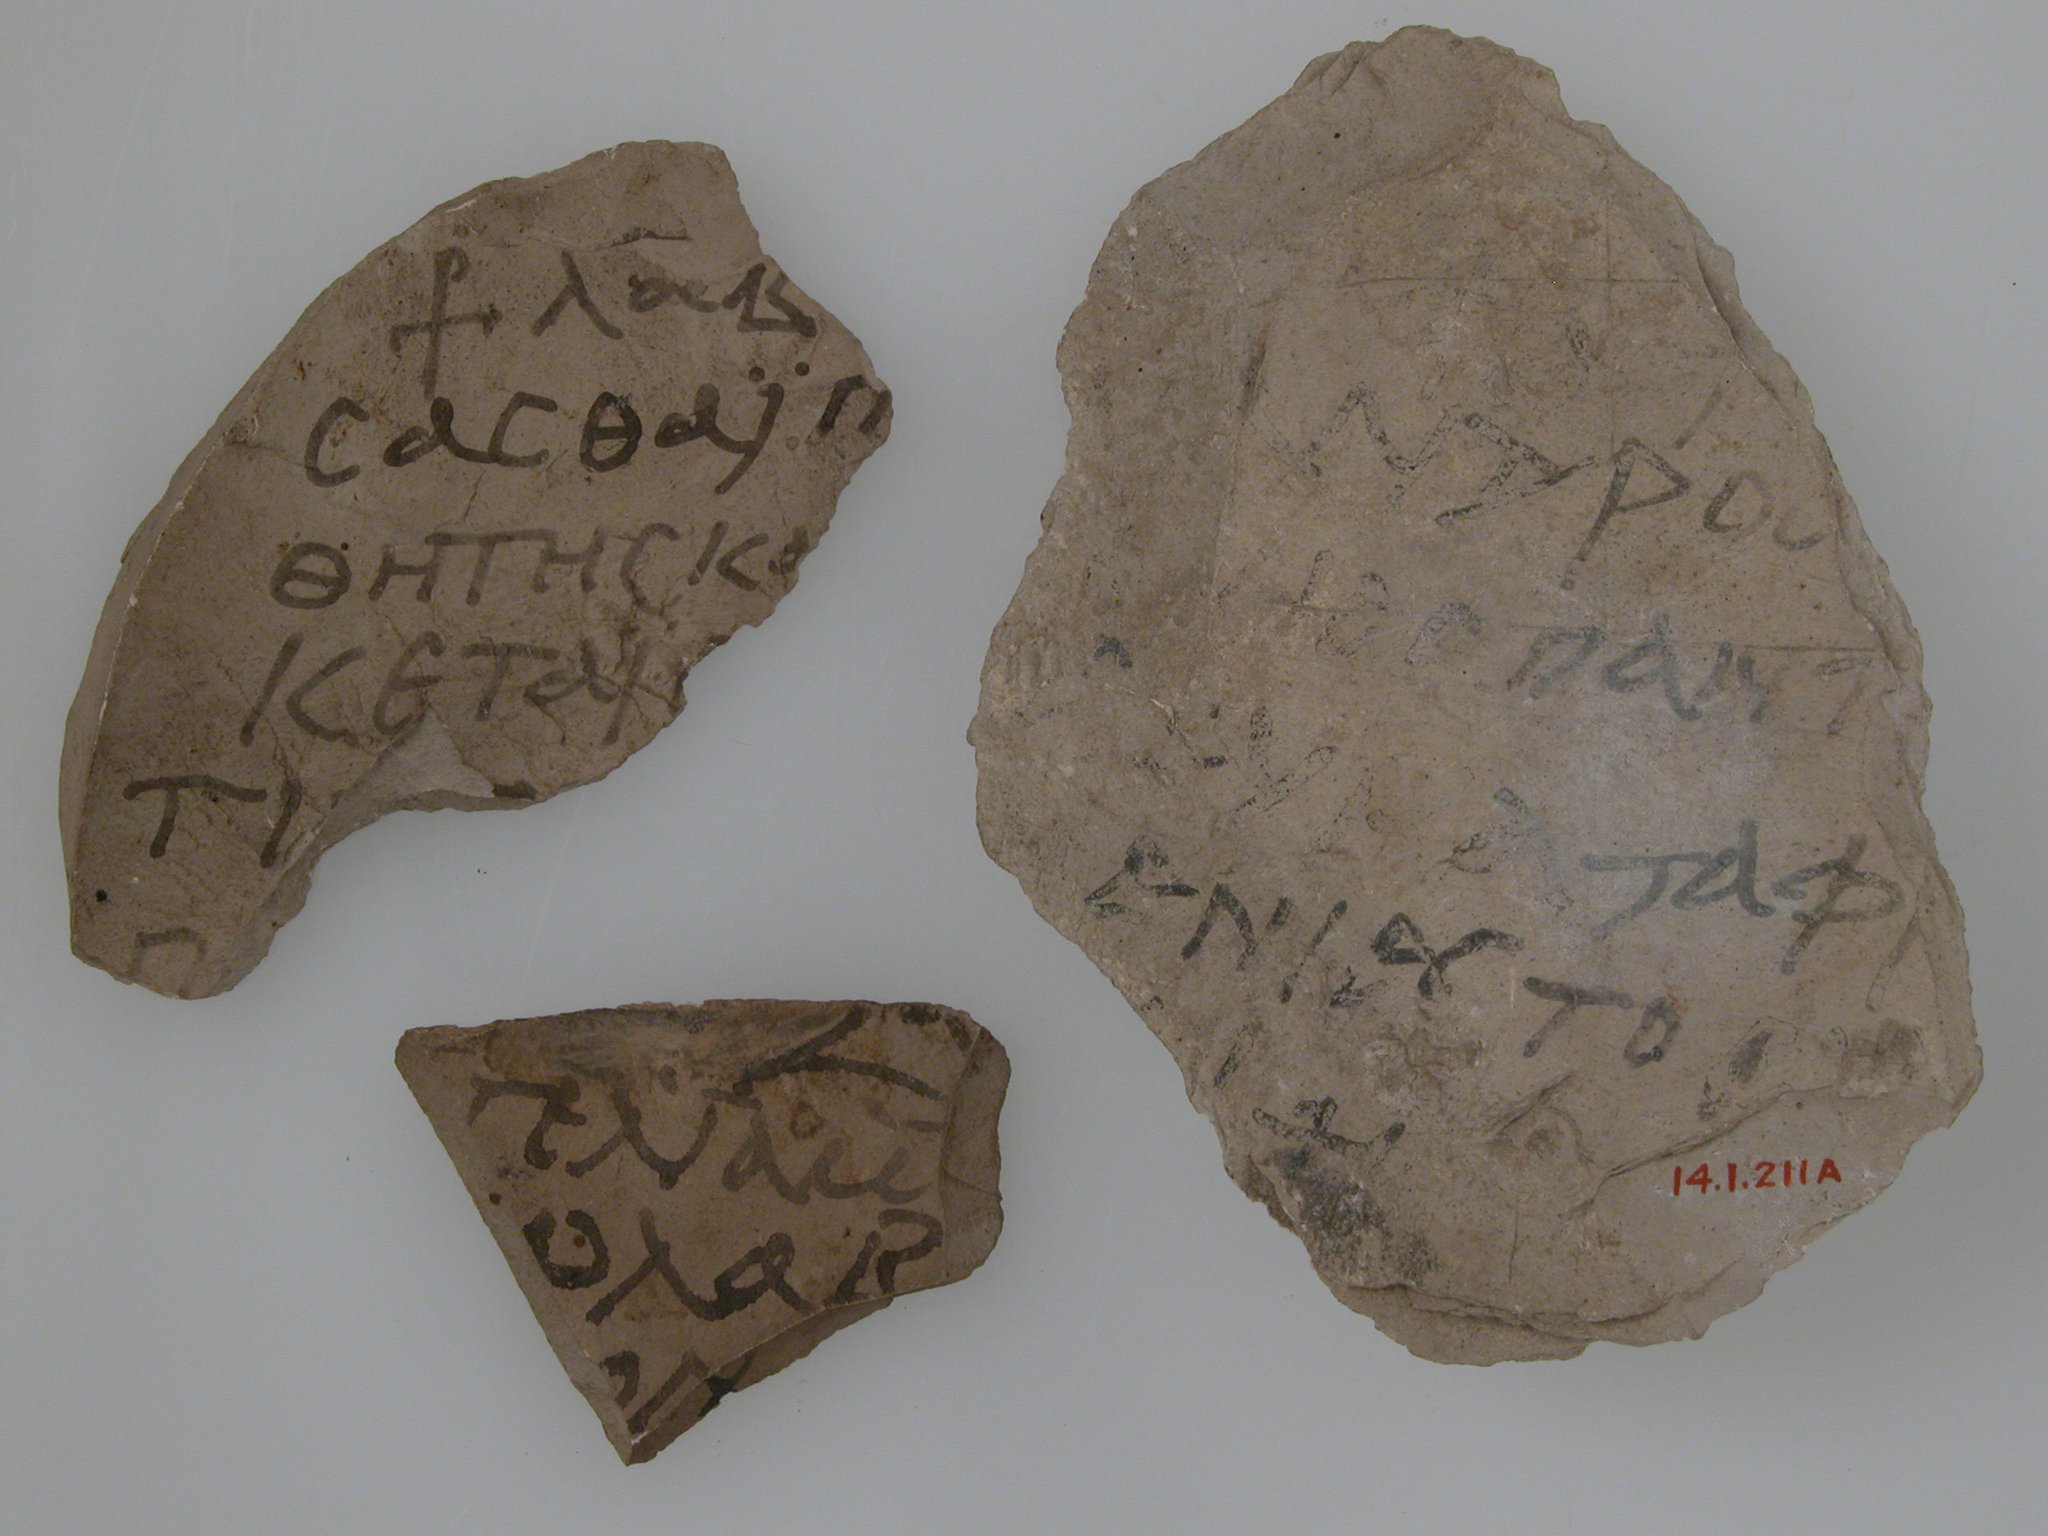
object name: ostrakon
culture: coptic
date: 580-640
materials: ink, limestone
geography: egypt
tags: greek